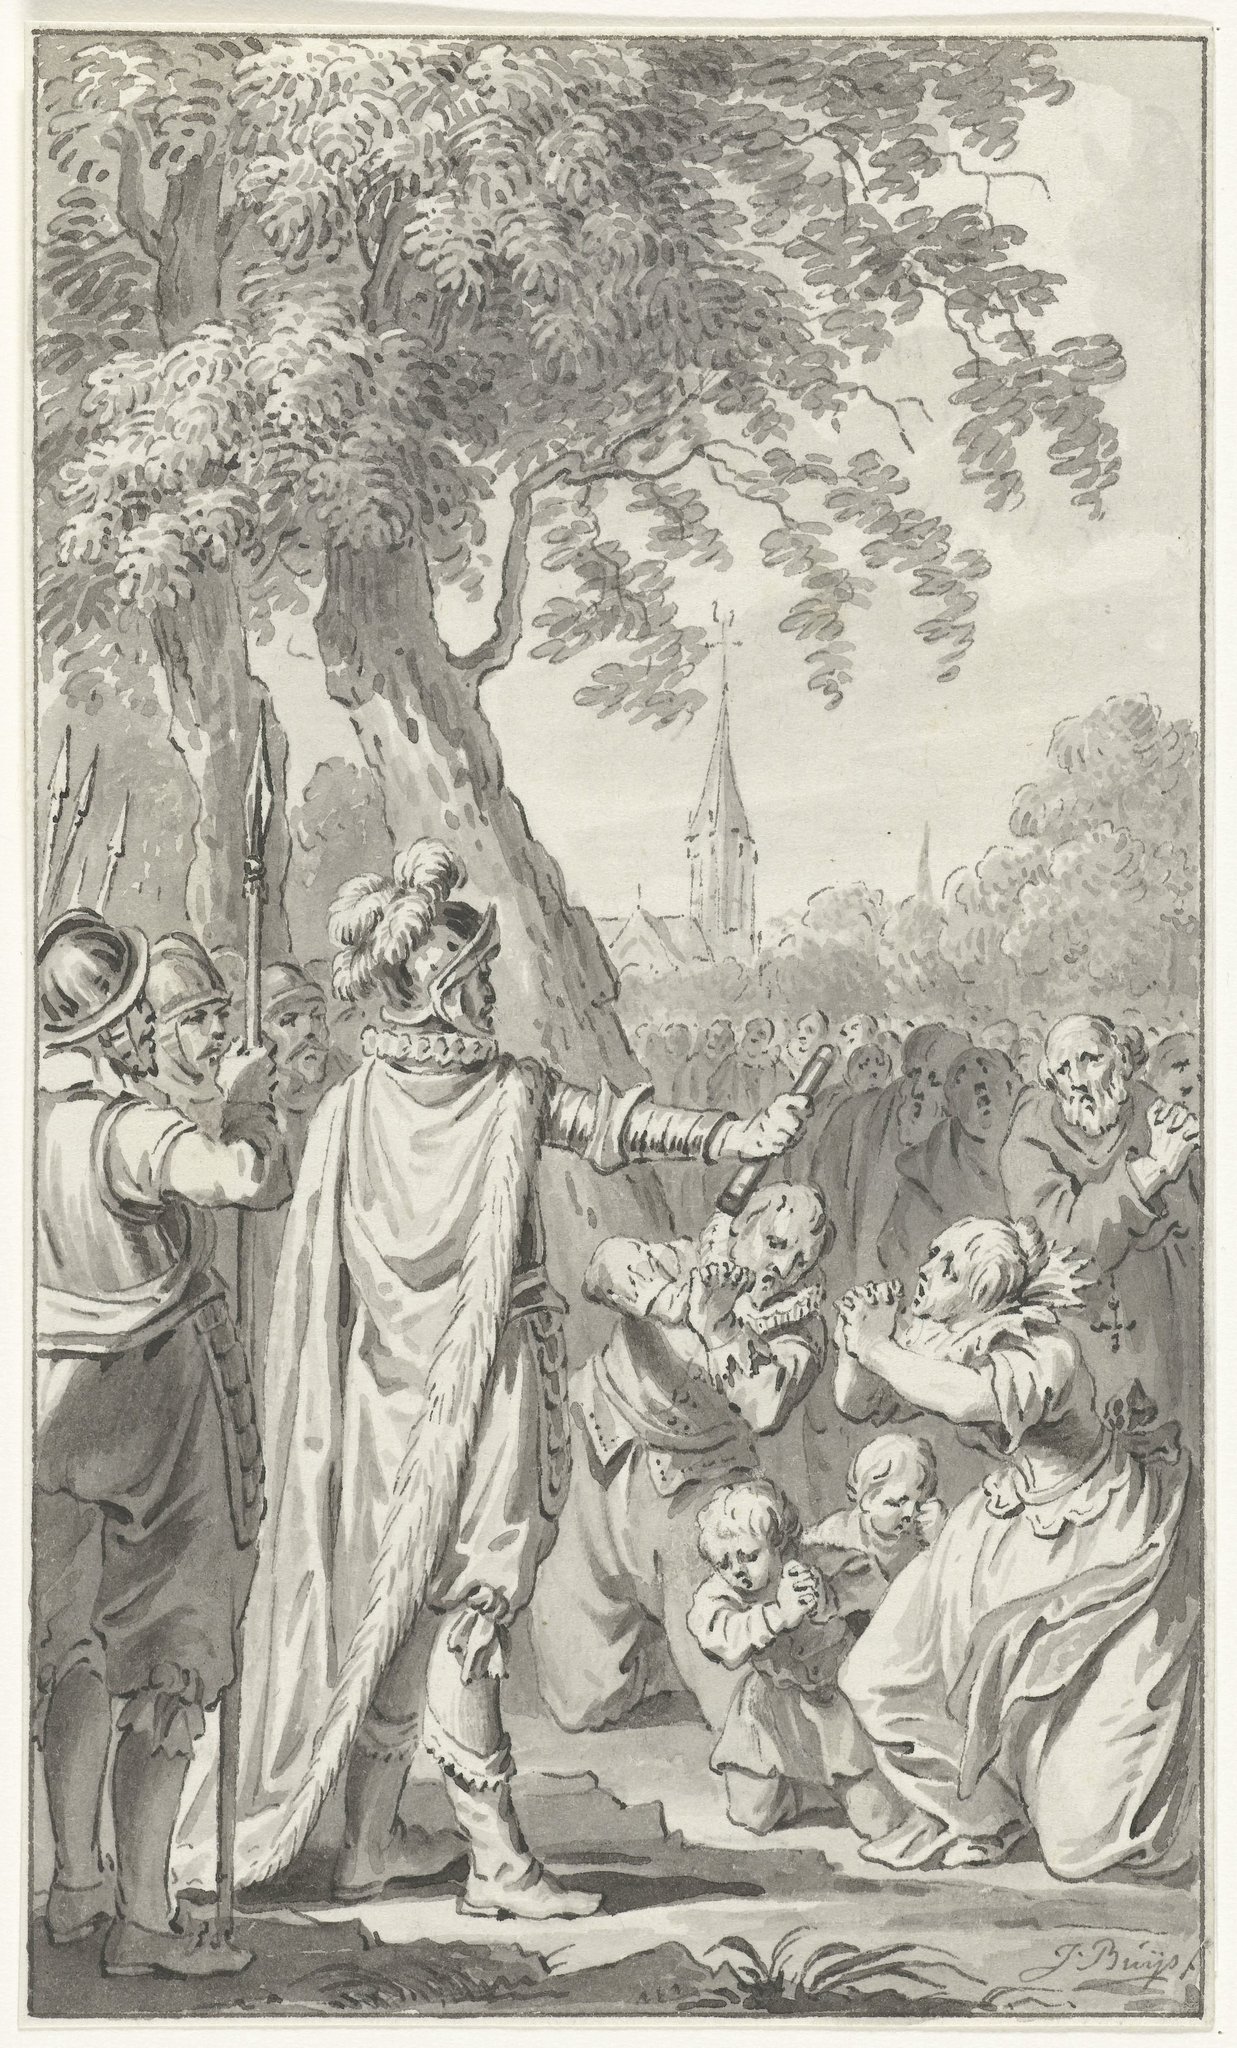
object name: history print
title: De inwoners van Zierikzee smeken Karel de Stoute, hertog van Bourgondië, om genade, 1472 (?)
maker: jacobus buys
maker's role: draughtsman, print maker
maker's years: 1724-1801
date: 1793-1795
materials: ink, paper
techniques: brush, pen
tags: earl, charles the bold (duke of burgundy), historical persons, the defeated before the victor, historical events and situations, burgundian netherlands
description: Ontwerptekening voor de illustratie in: Jacobus Kok, Vaderlandsch Woordenboek, Johannes Allart, Amsterdam 1785-1799, 35 delen, dl. XXXIV, pl. III.